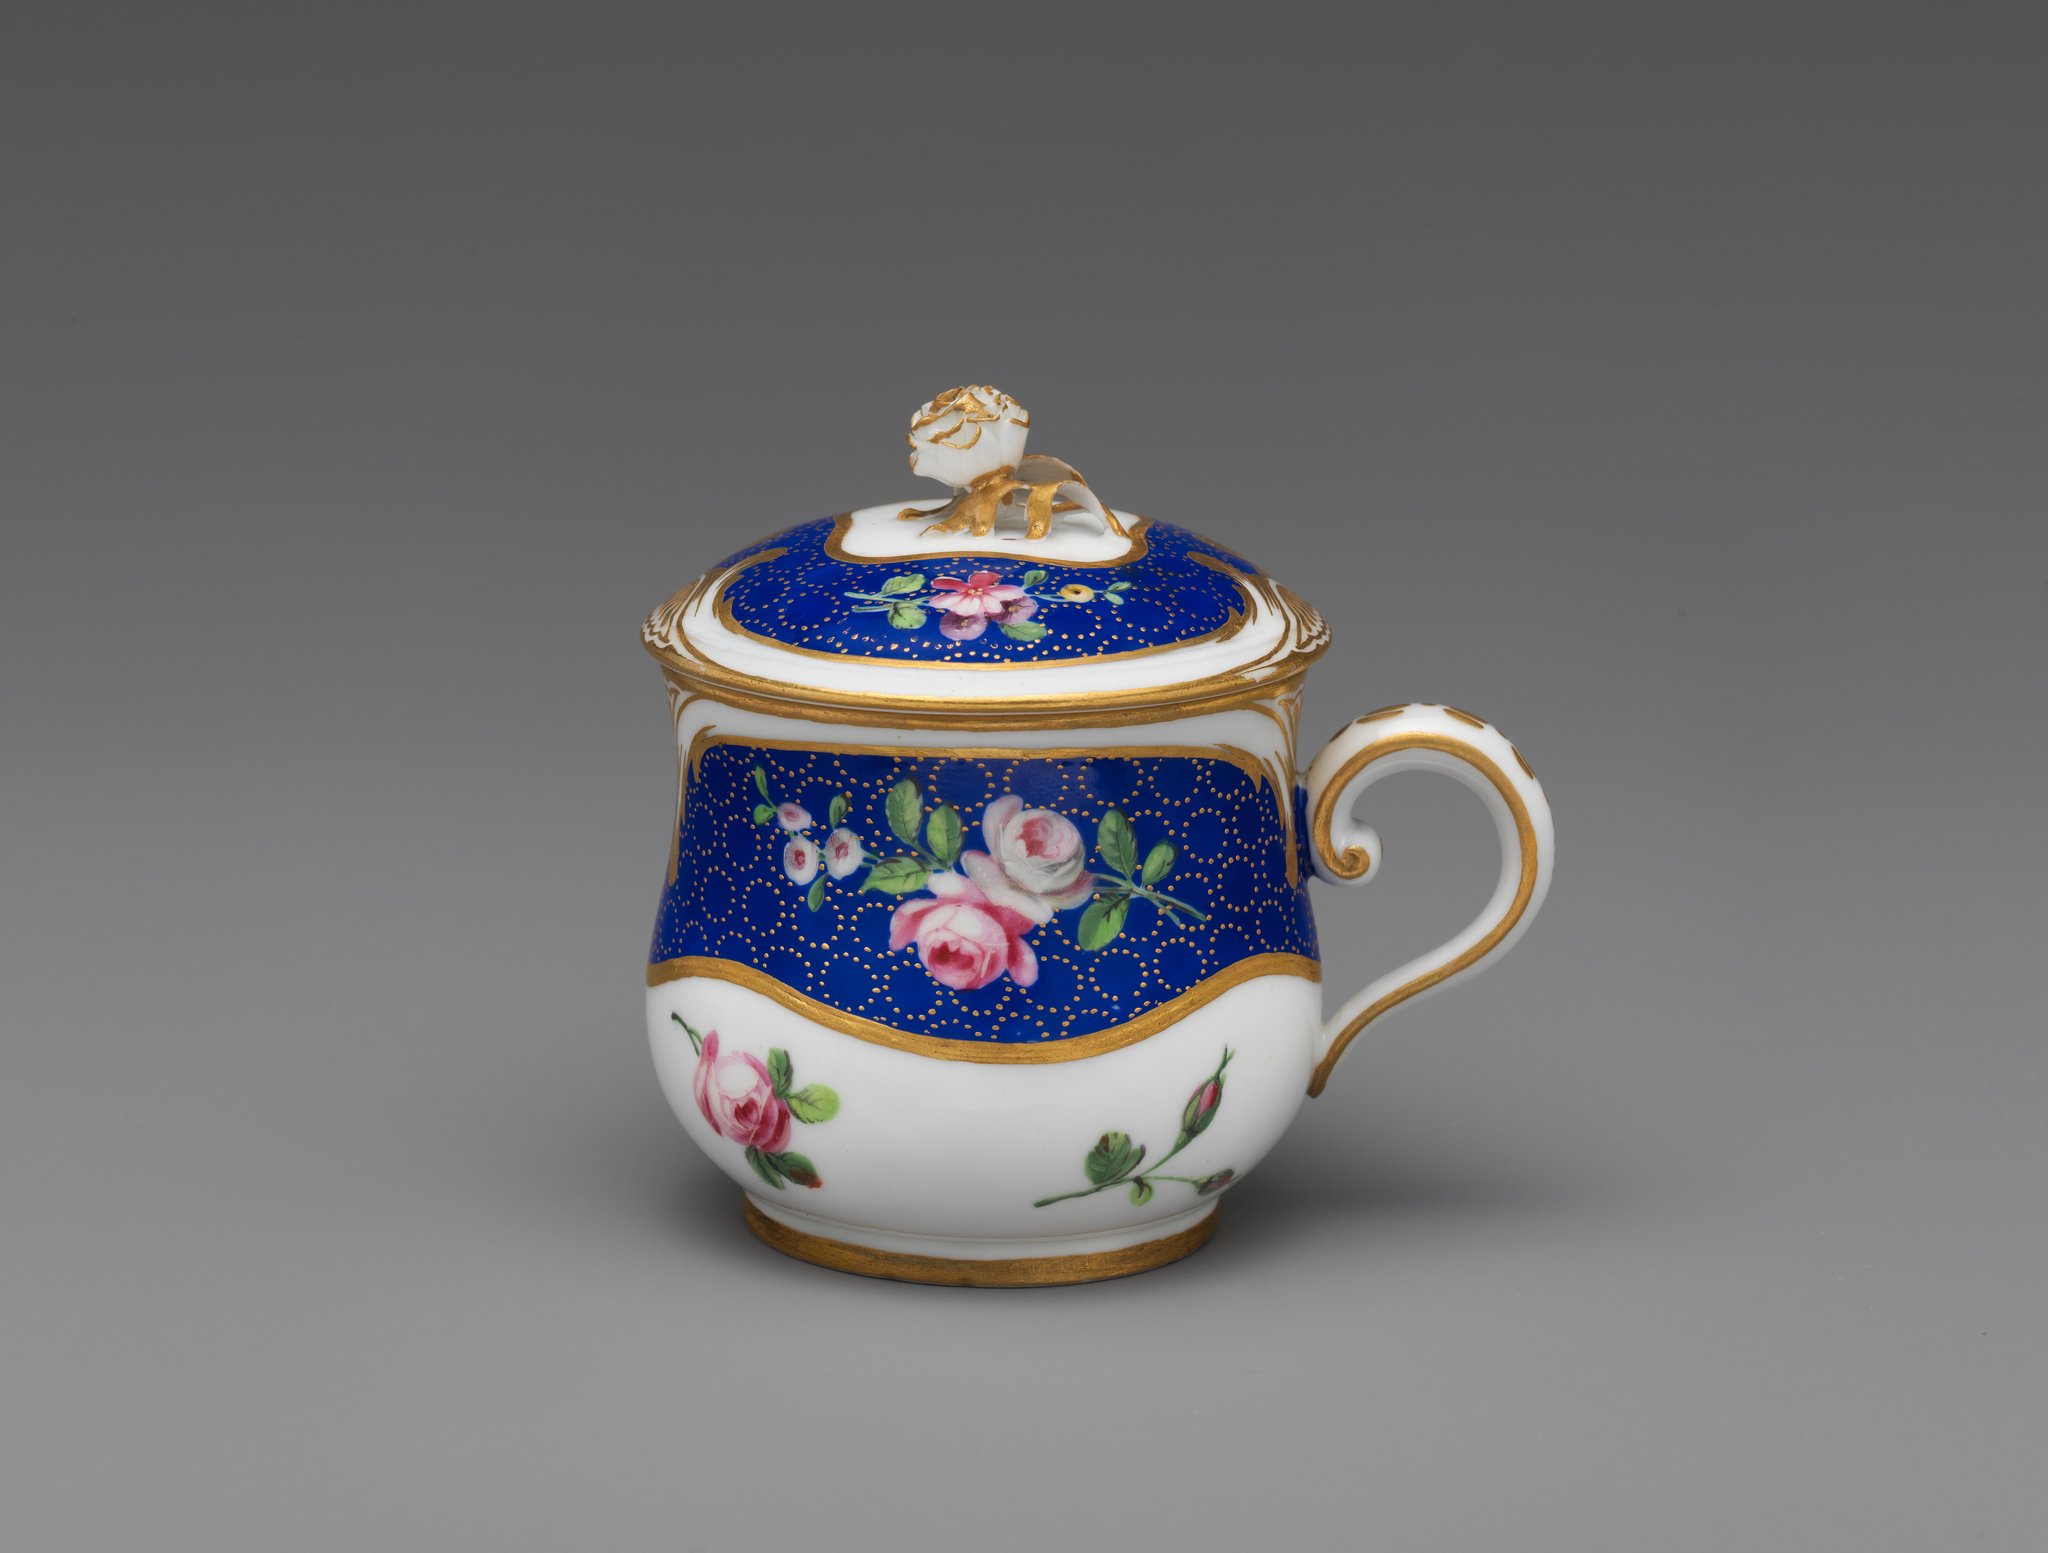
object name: cup with cover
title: Cup with cover (pot à jus)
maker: sèvres manufactory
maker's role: manufactory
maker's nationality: french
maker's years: 1740-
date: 1771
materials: soft paste porcelain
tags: roses